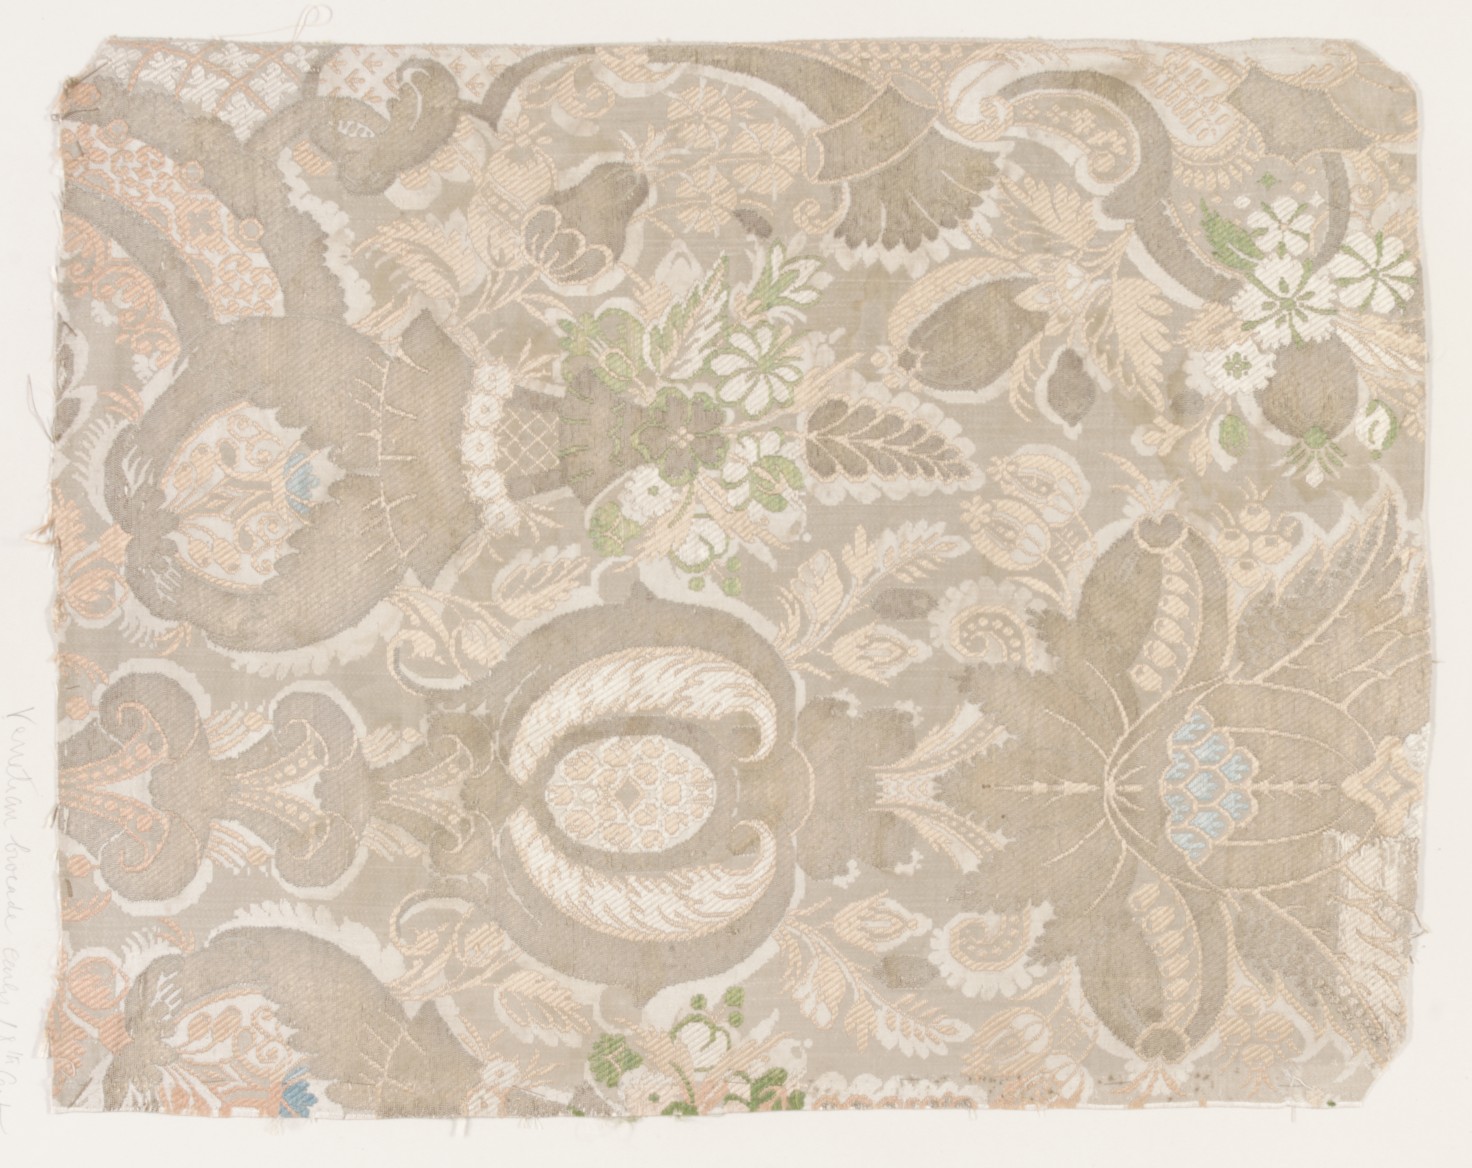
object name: fragment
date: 1701-1733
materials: metal thread, silk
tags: flowers,leaves